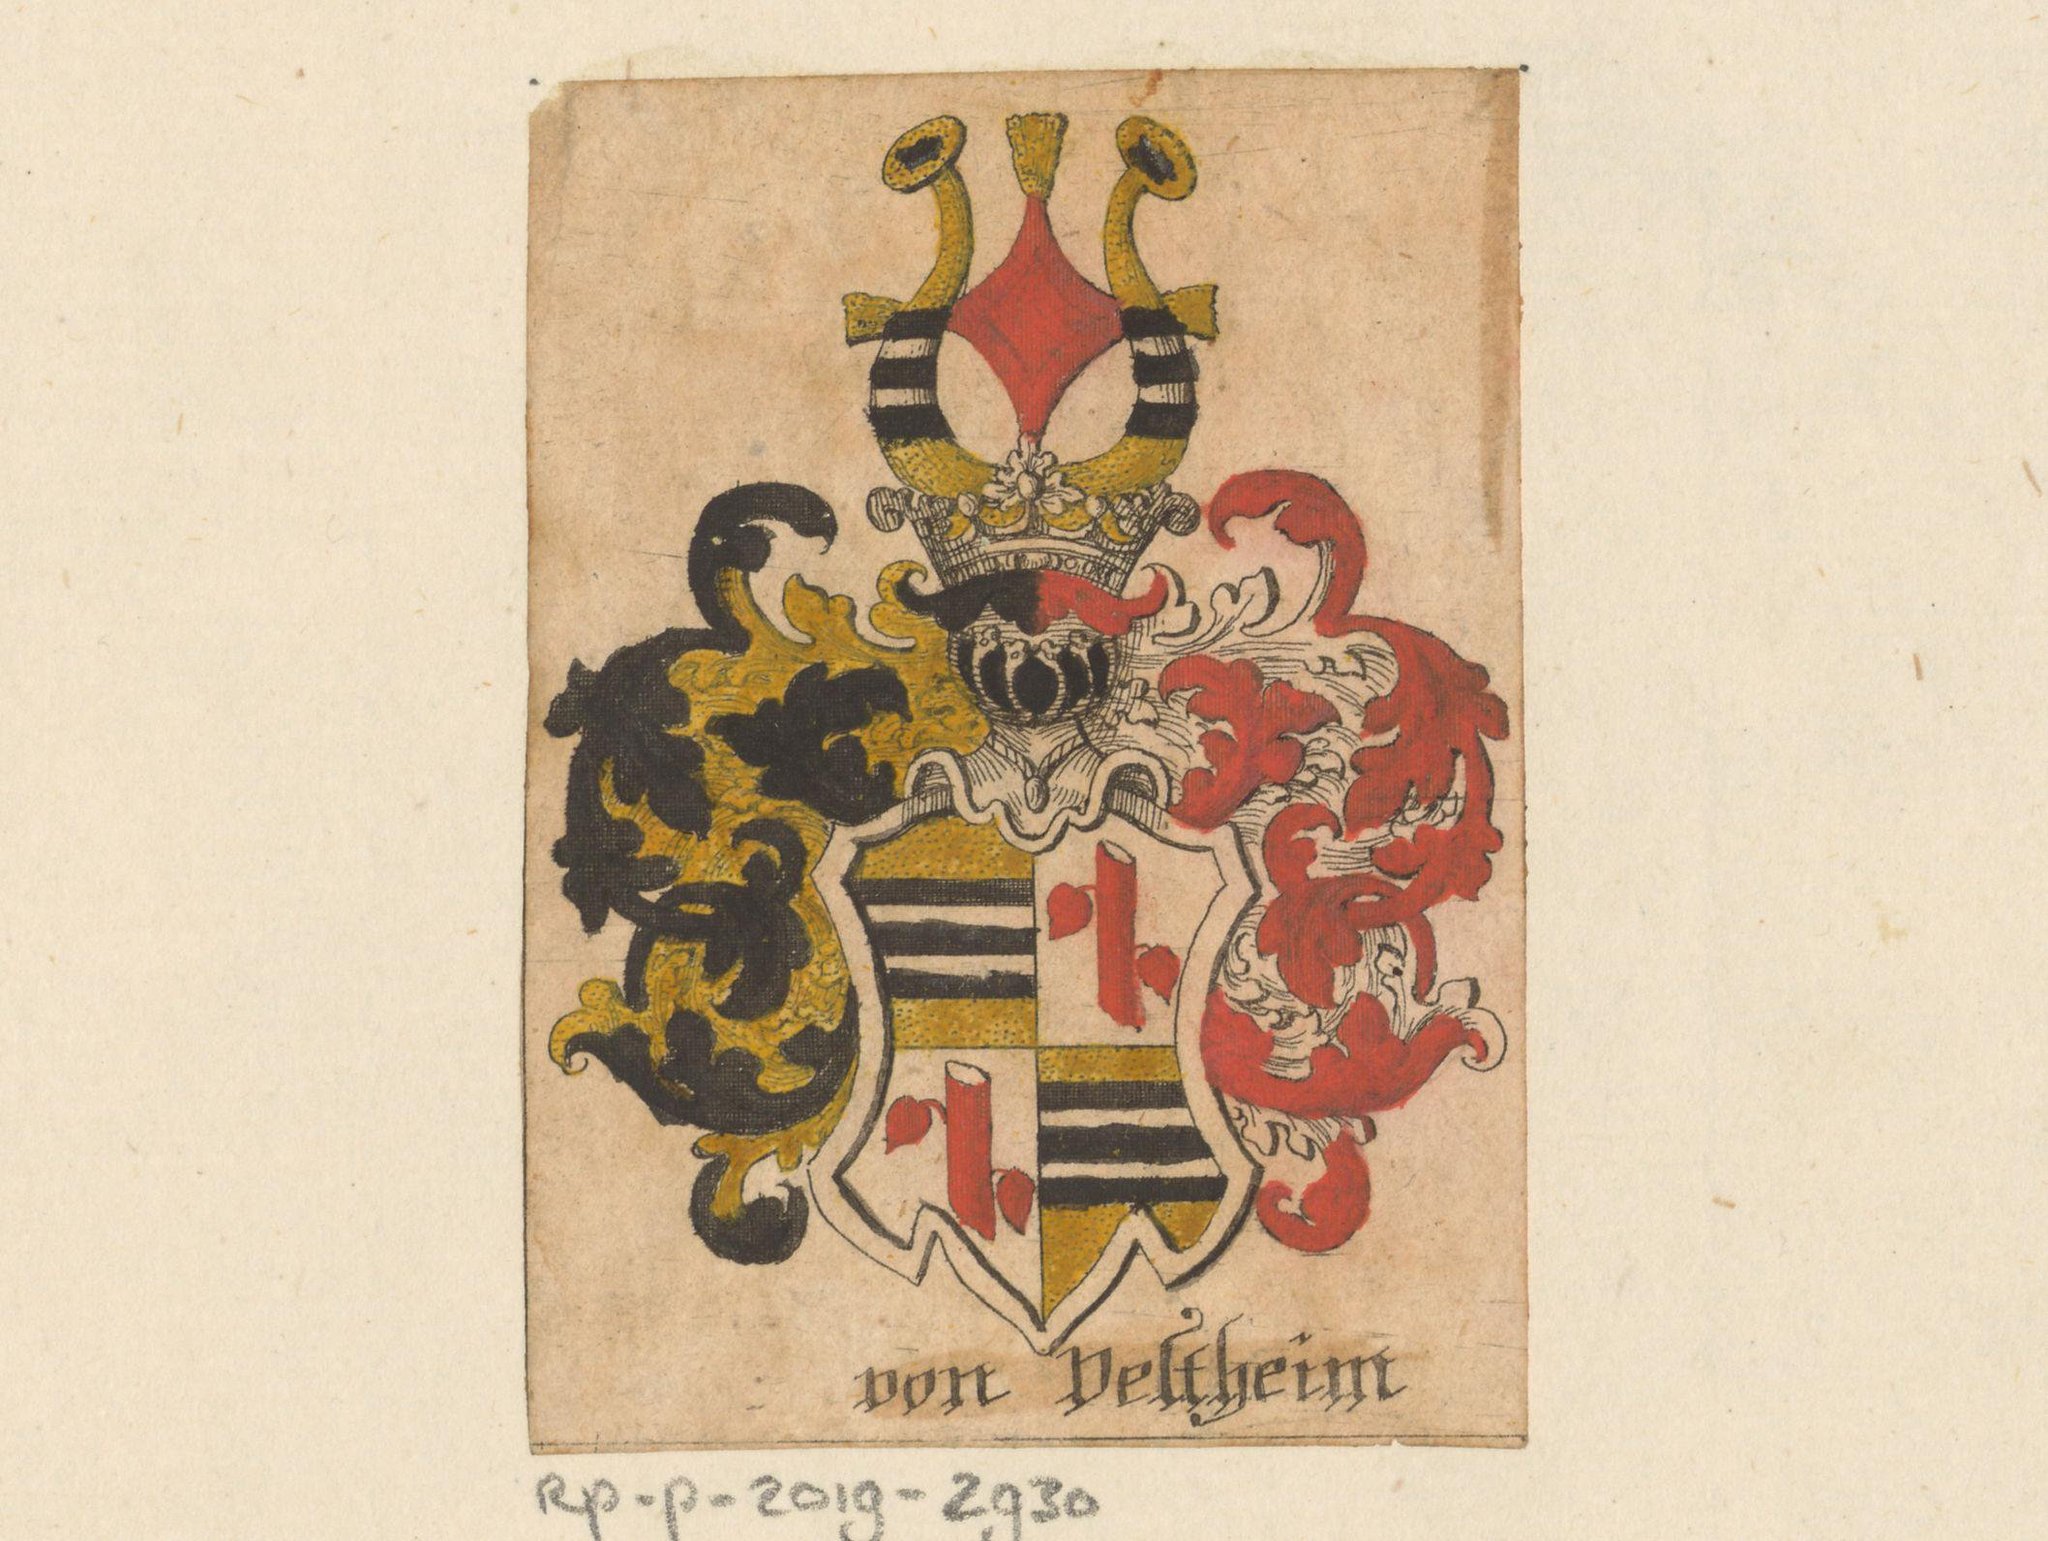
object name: bookplate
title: Ex libris van von Veltheim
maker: Anonymous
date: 1600-1749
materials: paper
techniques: etching, hand coloring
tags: armorial bearing, heraldry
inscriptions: collector's mark: Lugt 2166